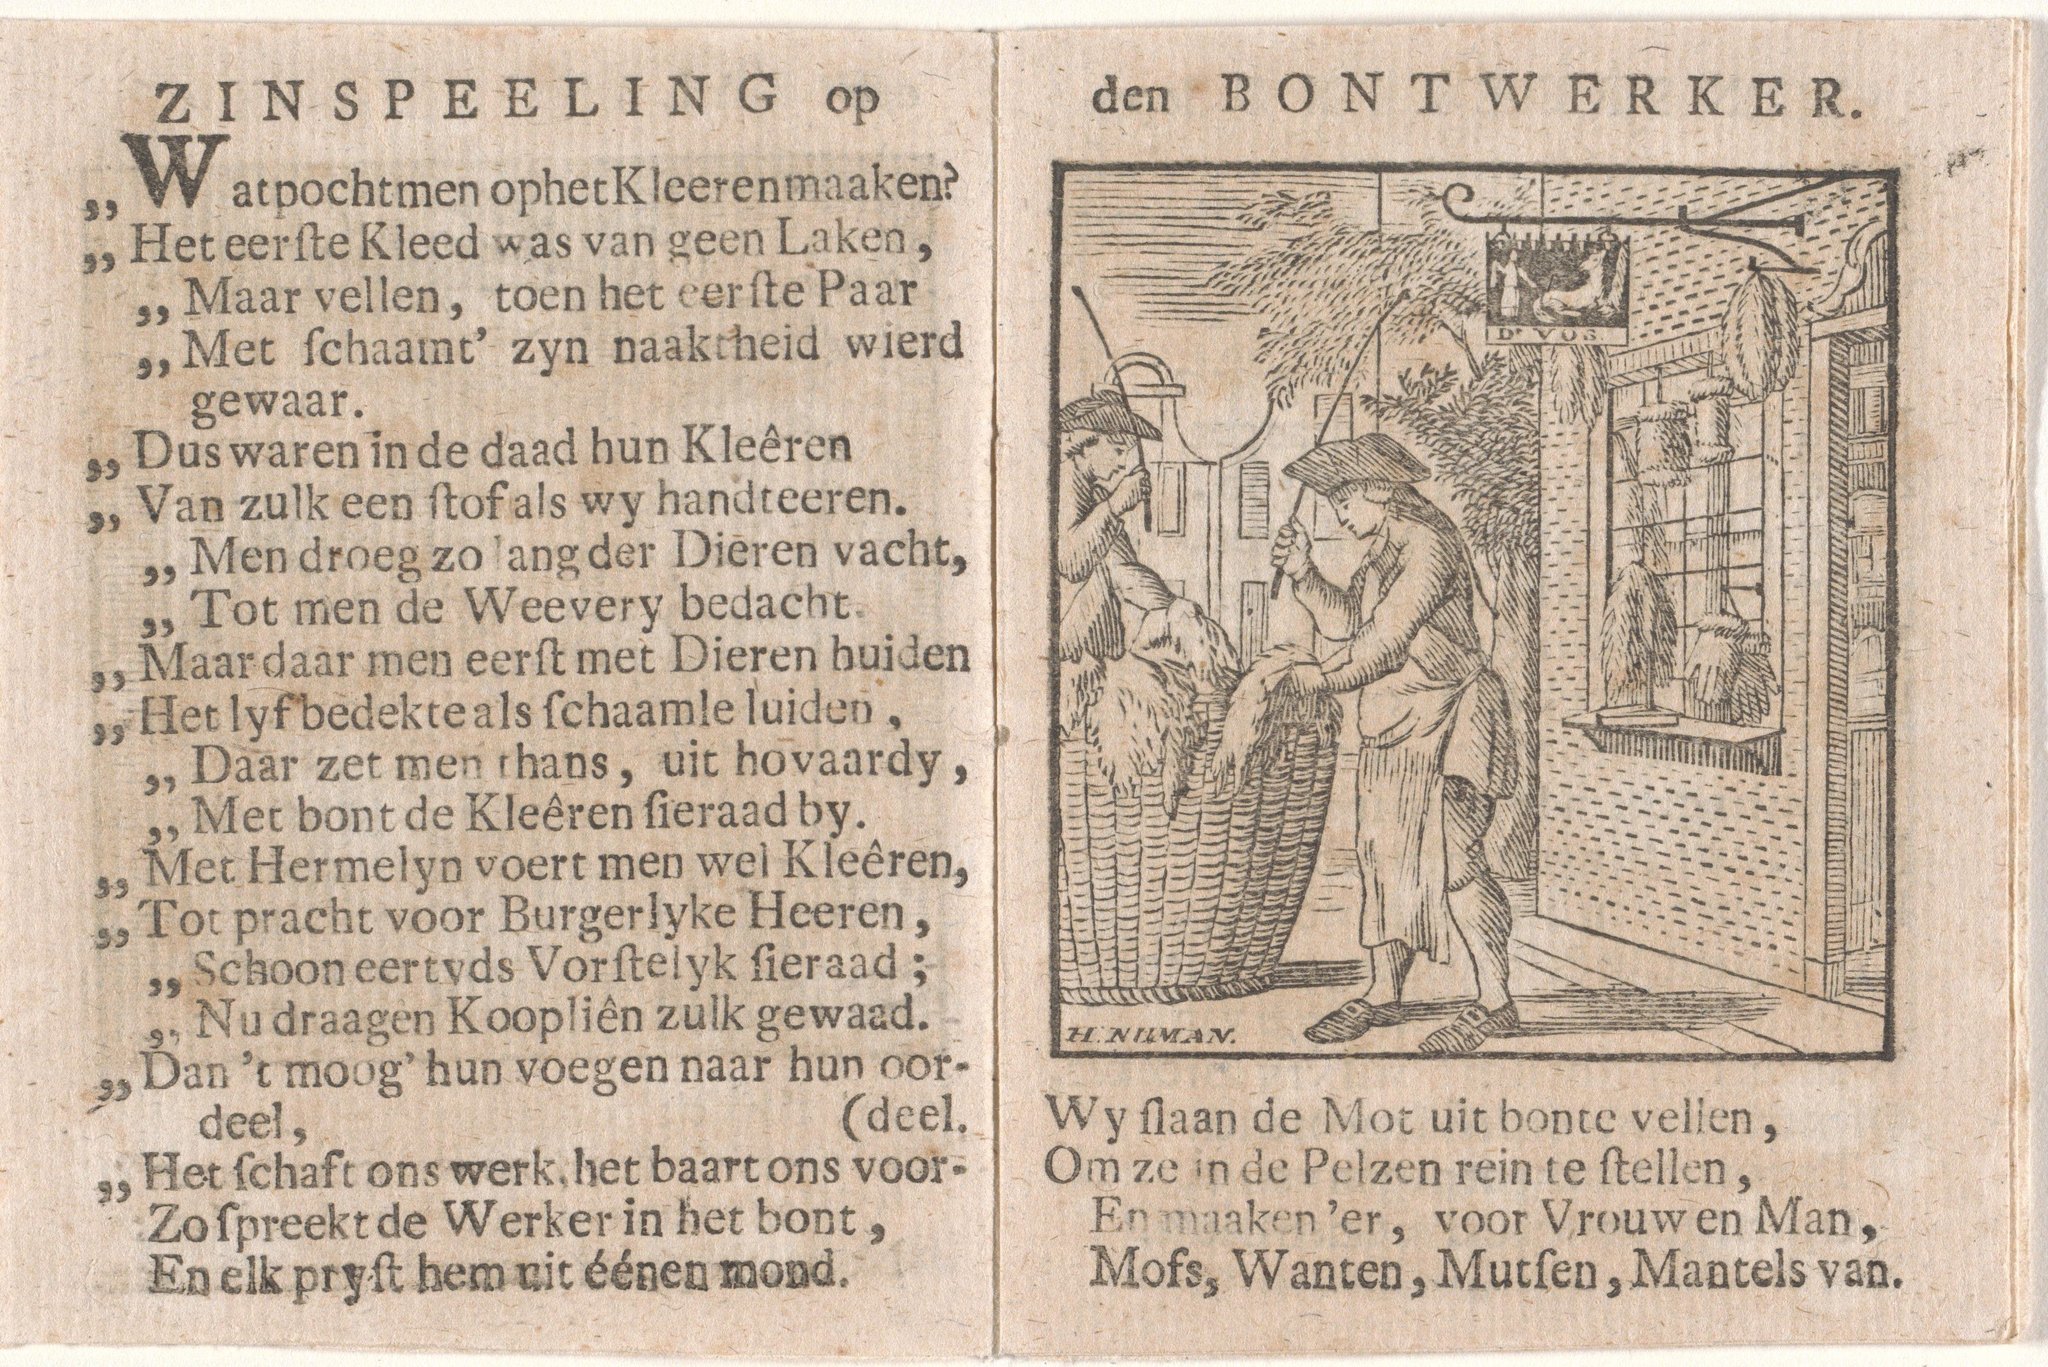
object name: book illustration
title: Zinspeeling op den bontwerker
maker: hendrik numan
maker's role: draughtsman, print maker, publisher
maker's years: 1736-1788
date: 1786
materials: paper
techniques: letterpress printing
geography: haarlem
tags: furrier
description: Prent uit: Zinspeelingen op allerlei wetenschappen, konsten en ambachten: Continuation 17. Amsterdam: erven weduwe Cornelis Stichter, 1786.